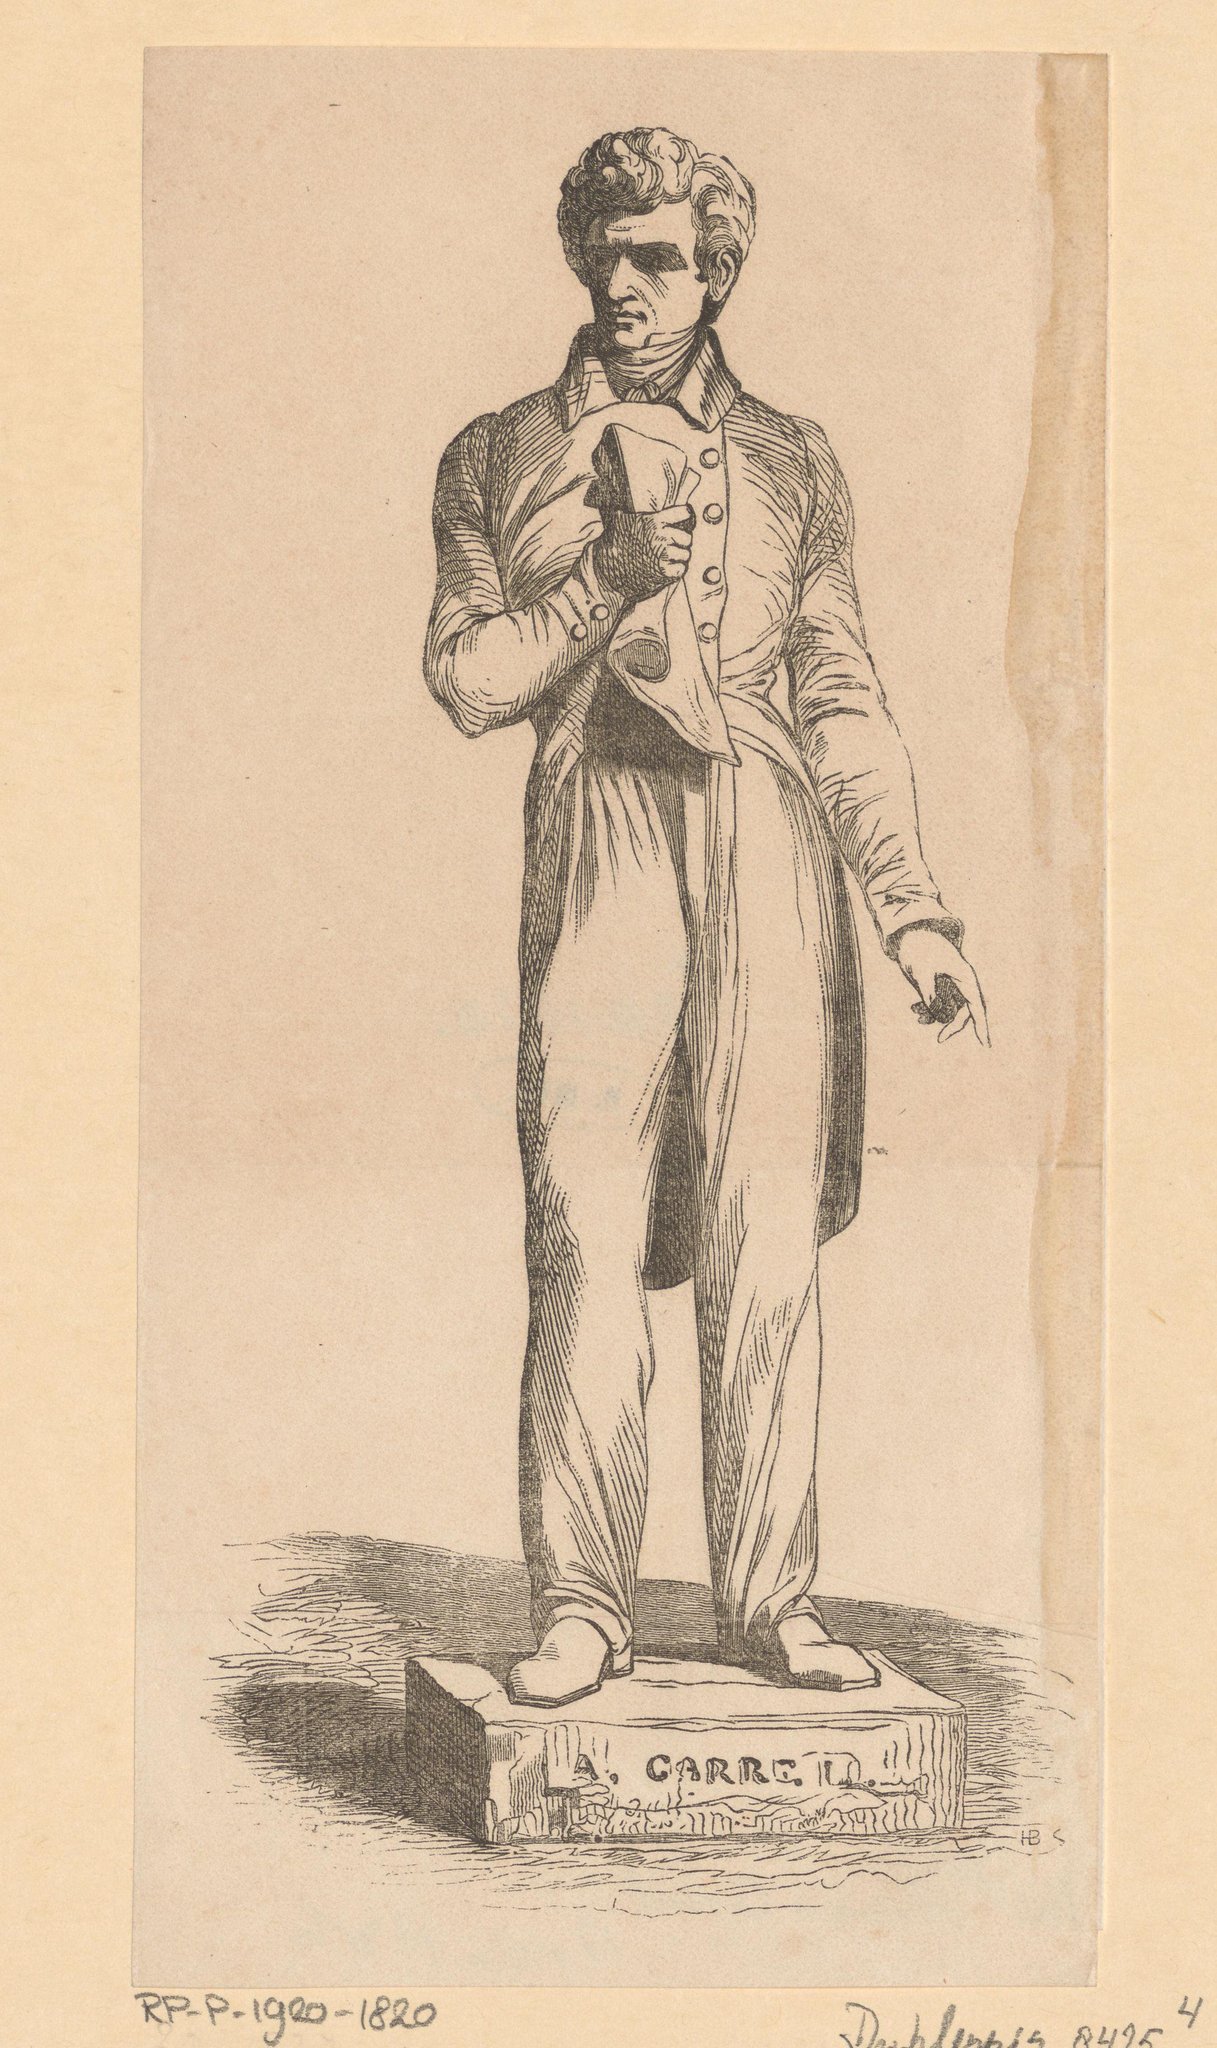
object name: print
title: Portret van Armand Carrel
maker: louis henri brévière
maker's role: print maker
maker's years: 1797-1869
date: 1839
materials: paper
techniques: engraving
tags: standing figure, historical persons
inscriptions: collector's mark: Lugt 2282